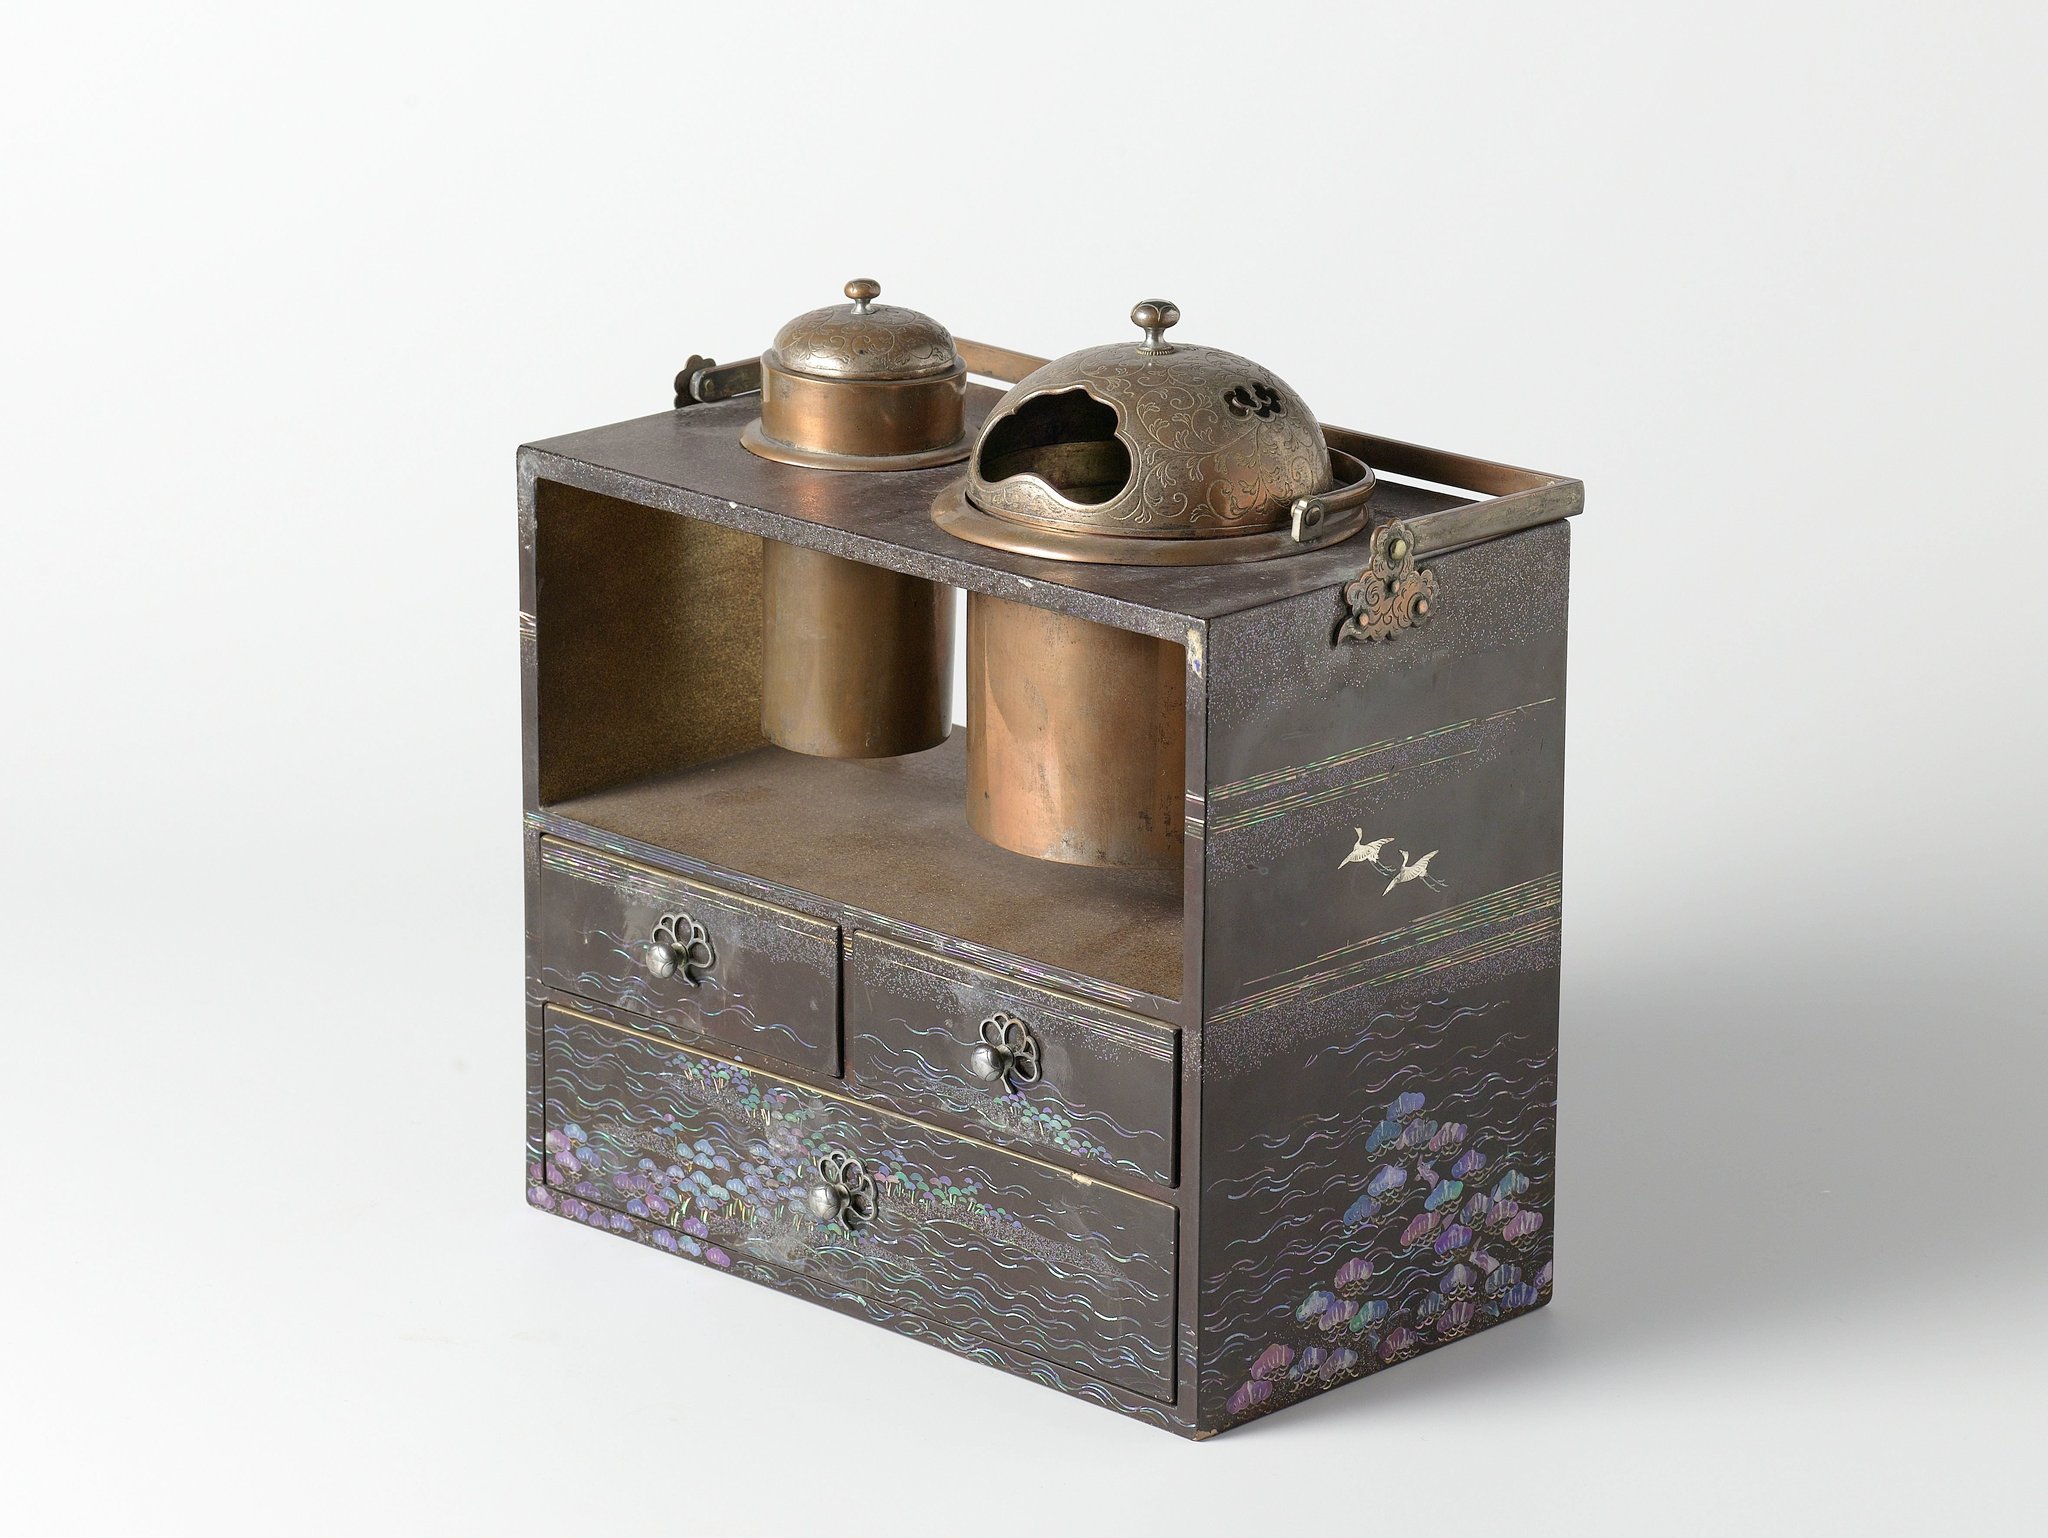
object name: rookstel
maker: Anonymous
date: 1400-1950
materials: lacquer